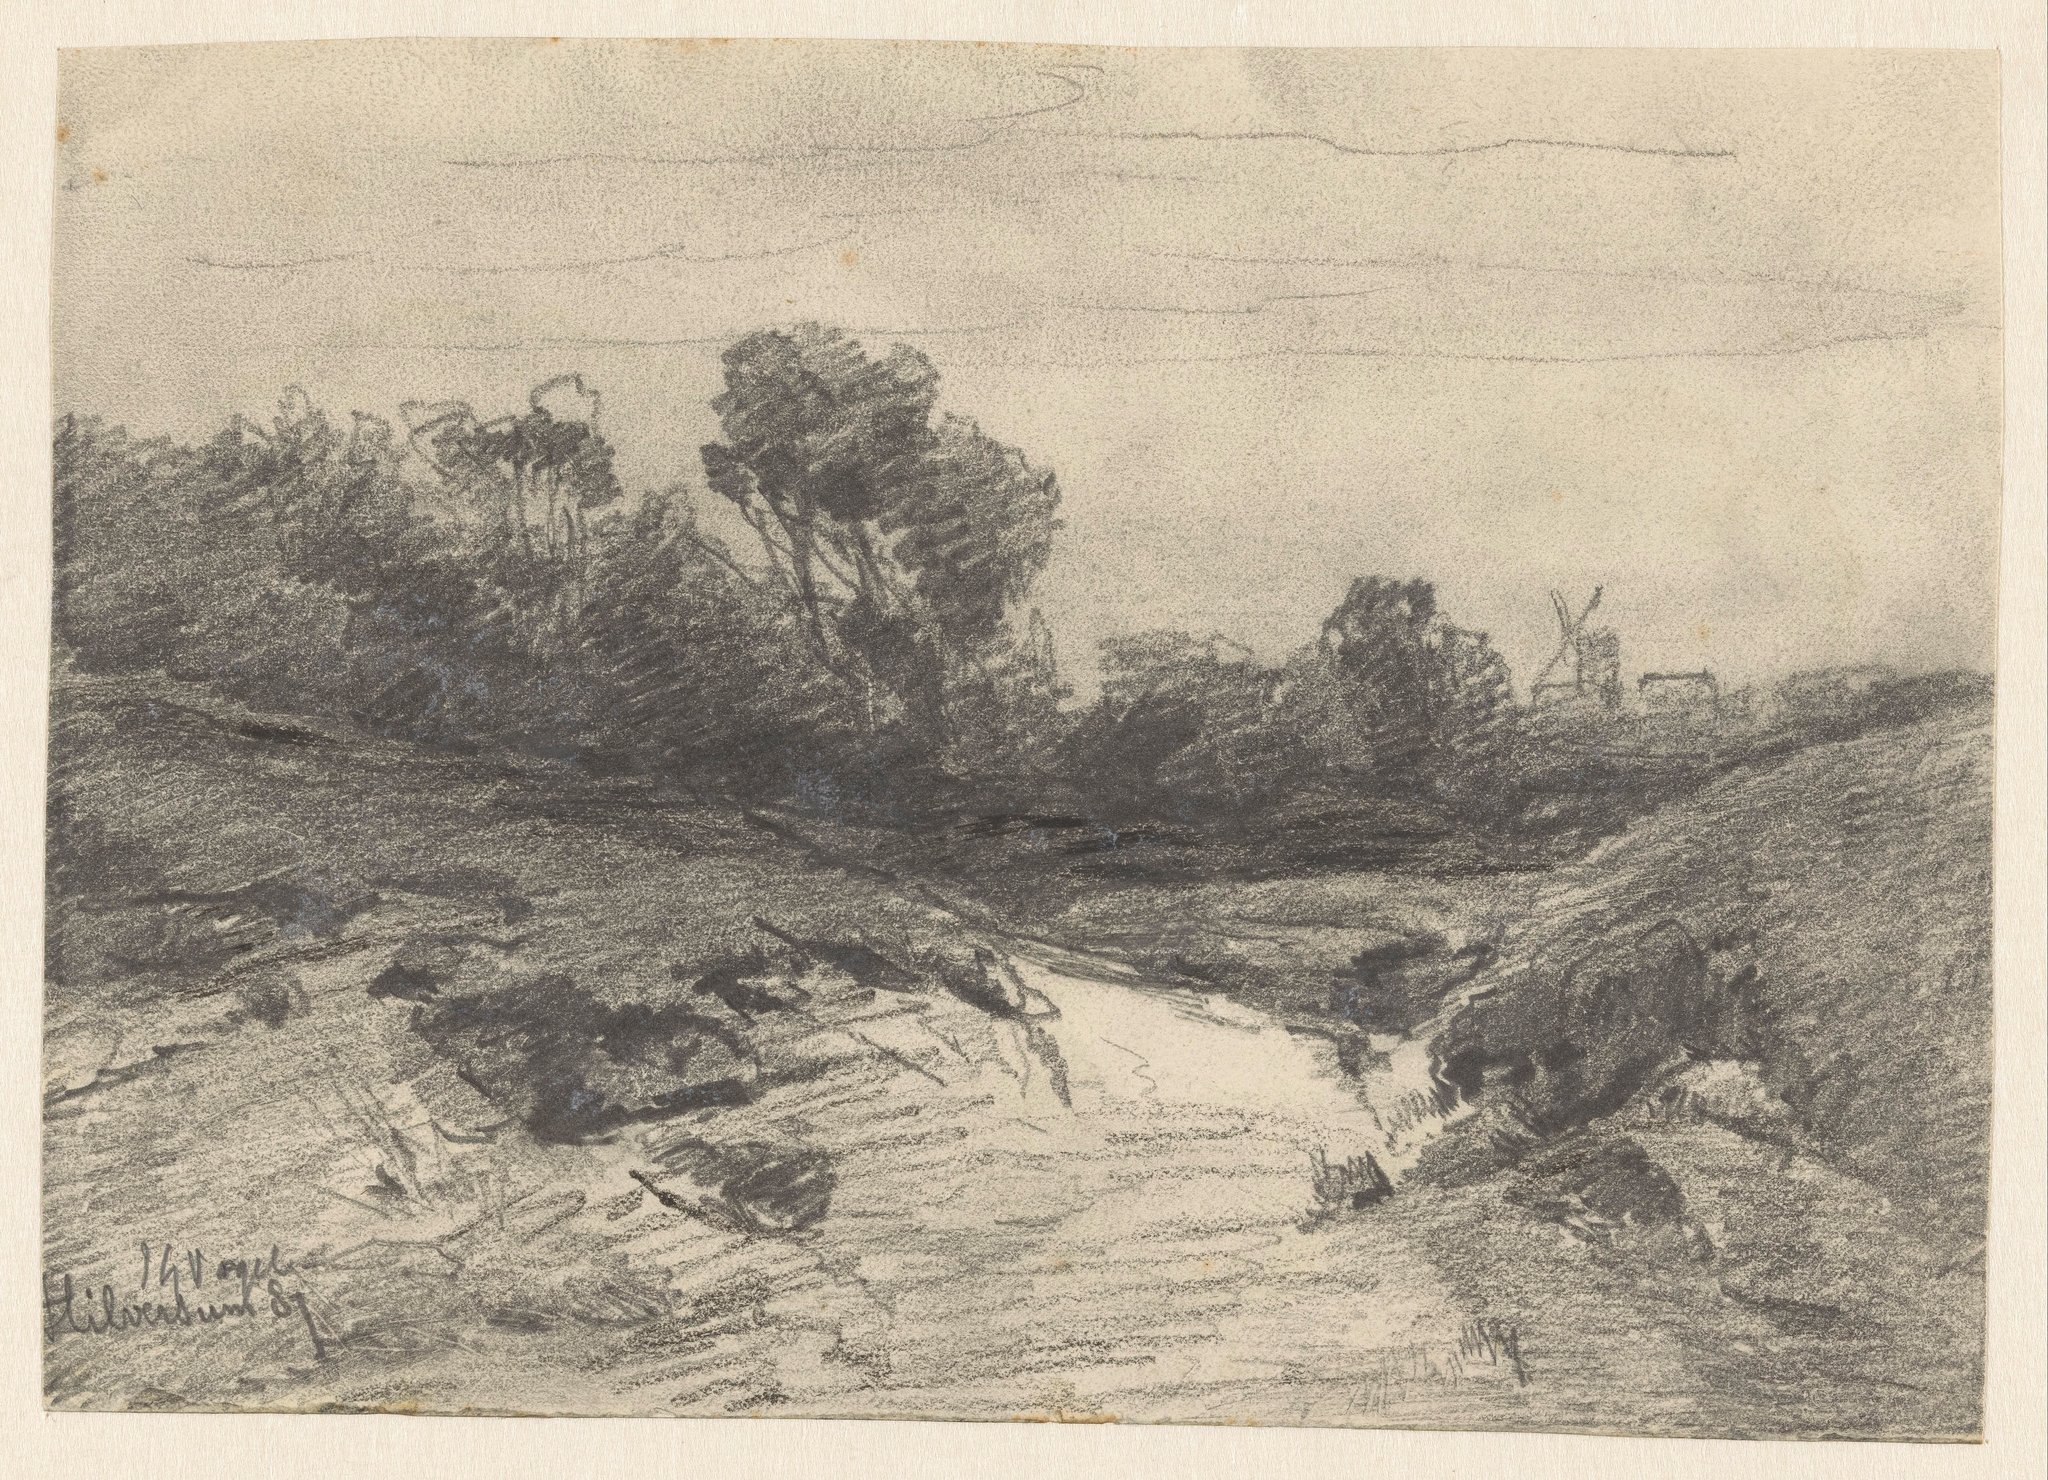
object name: drawing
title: Landschap met molen bij Hilversum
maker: johannes gijsbert vogel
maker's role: draughtsman, painter, print maker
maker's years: 1828-1915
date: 1887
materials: chalk, paper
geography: hilversum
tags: factories and mills in landscape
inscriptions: date